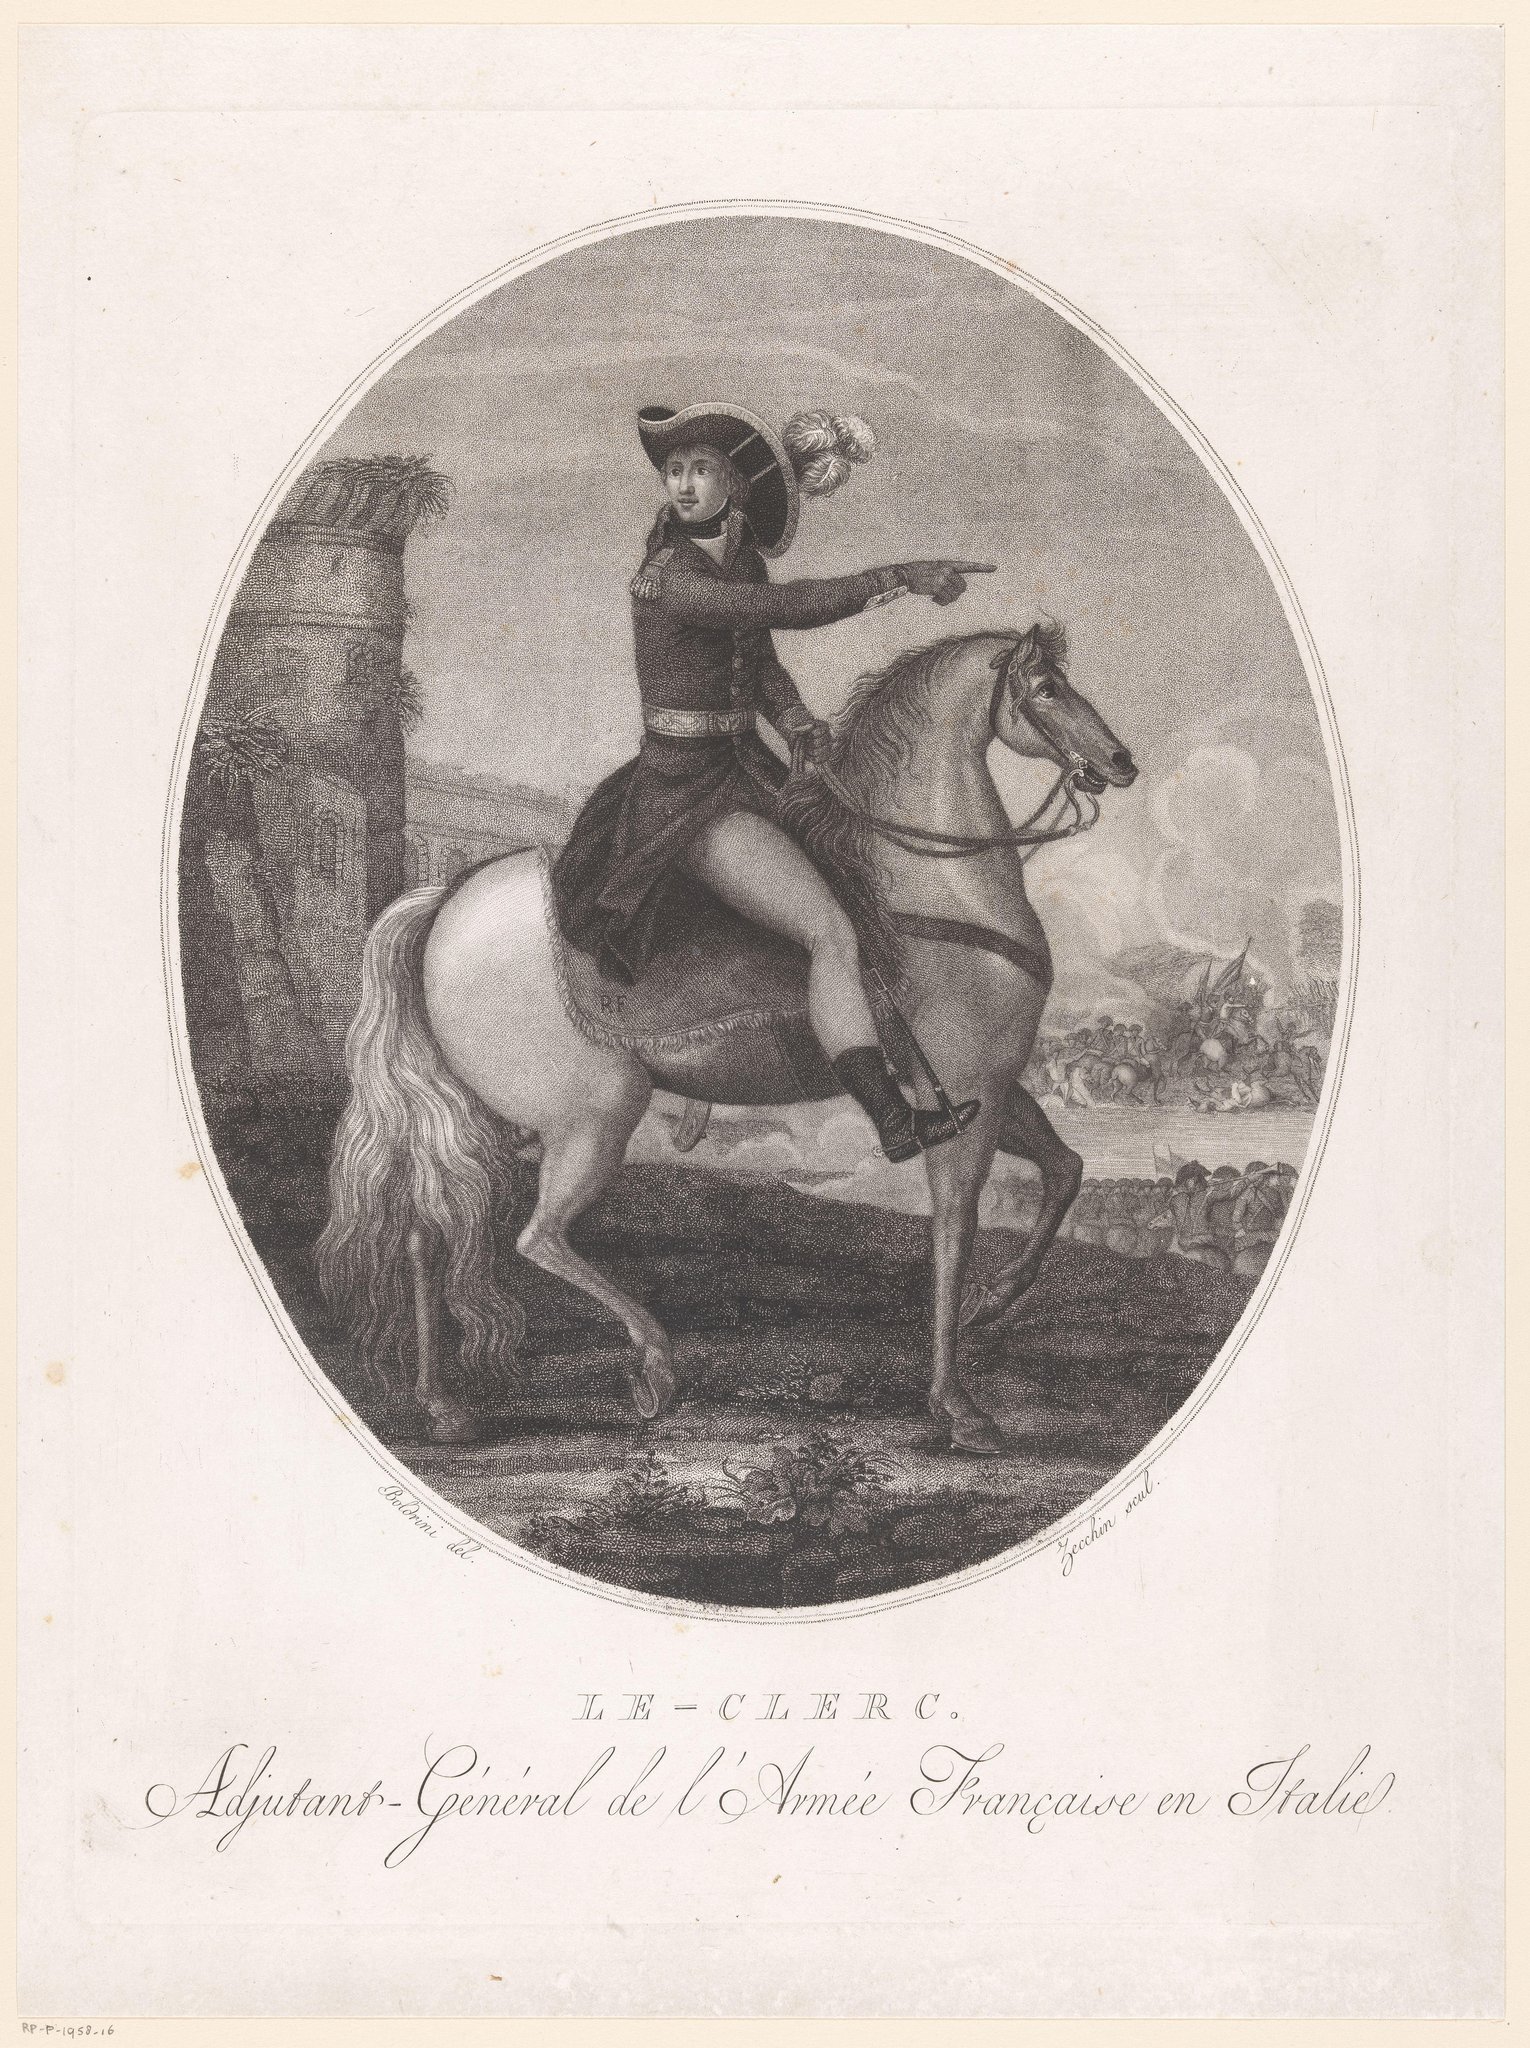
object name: print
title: Le-Clerc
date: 1790-1880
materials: paper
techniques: engraving, etching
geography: italy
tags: commander-in-chief, general, marshal, historical persons, horse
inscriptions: collector's mark: Lugt 2228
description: Portret van een man te paard, volgens het onderschrift genaamd Le-Clerc, adjudant-generaal van het Franse leger in Italië.